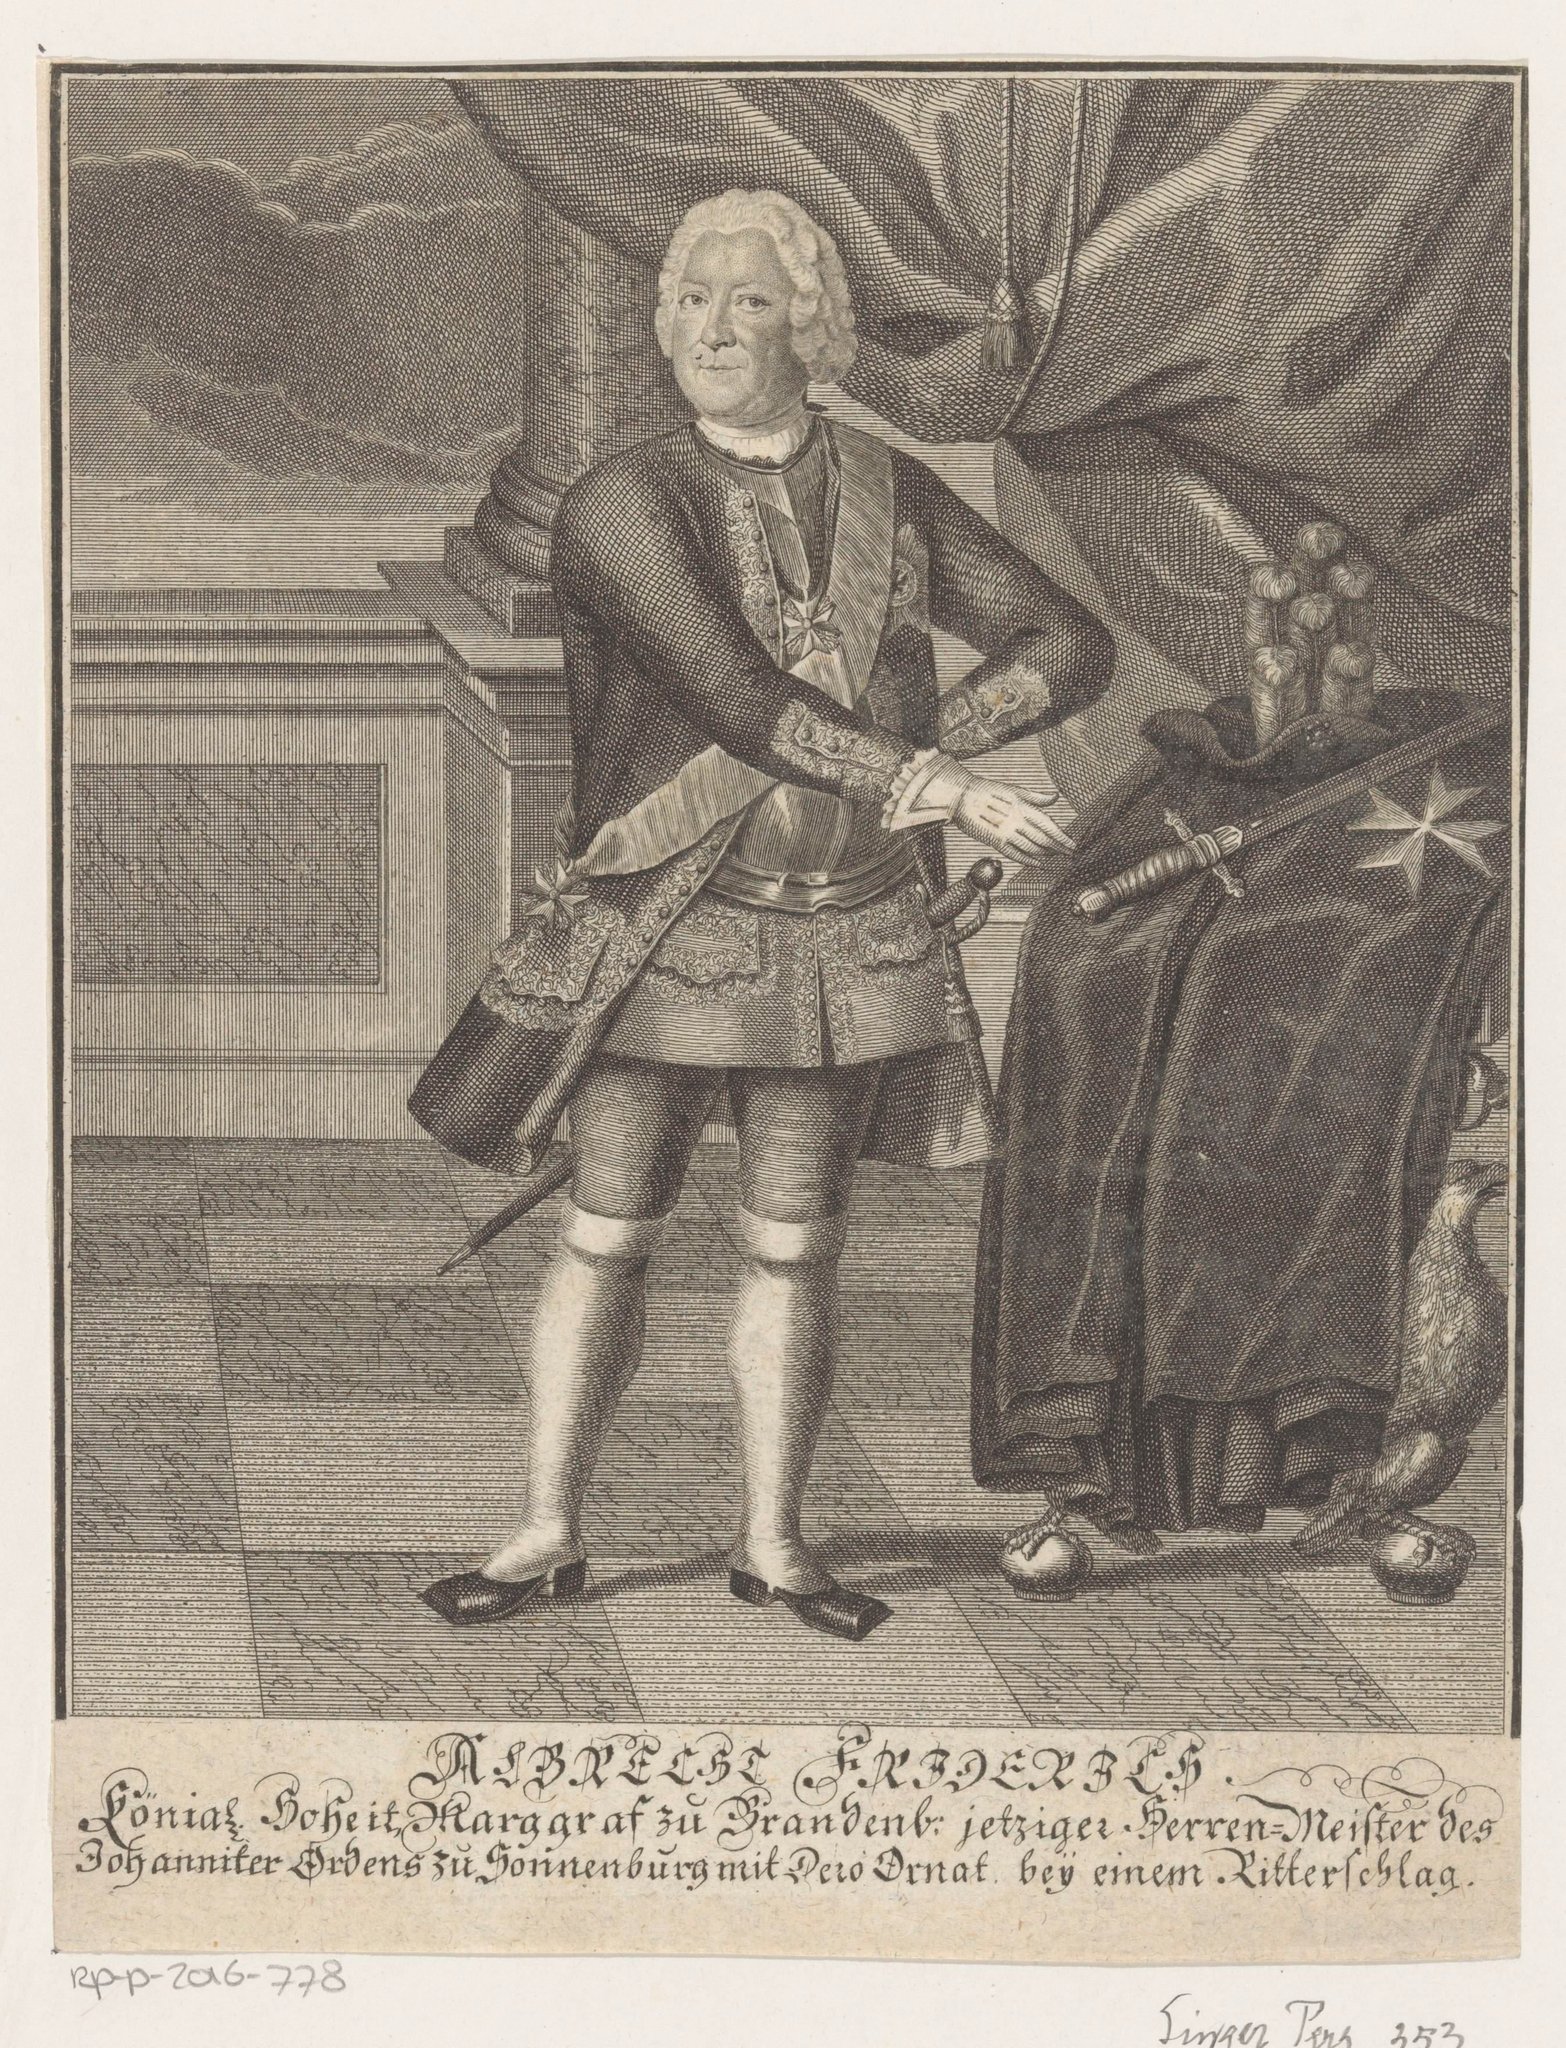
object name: print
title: Portret van Albrecht Friedrich van Brandenburg-Schwedt, prins van Pruisen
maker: Anonymous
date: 1700-1799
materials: paper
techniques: engraving, etching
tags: berlin